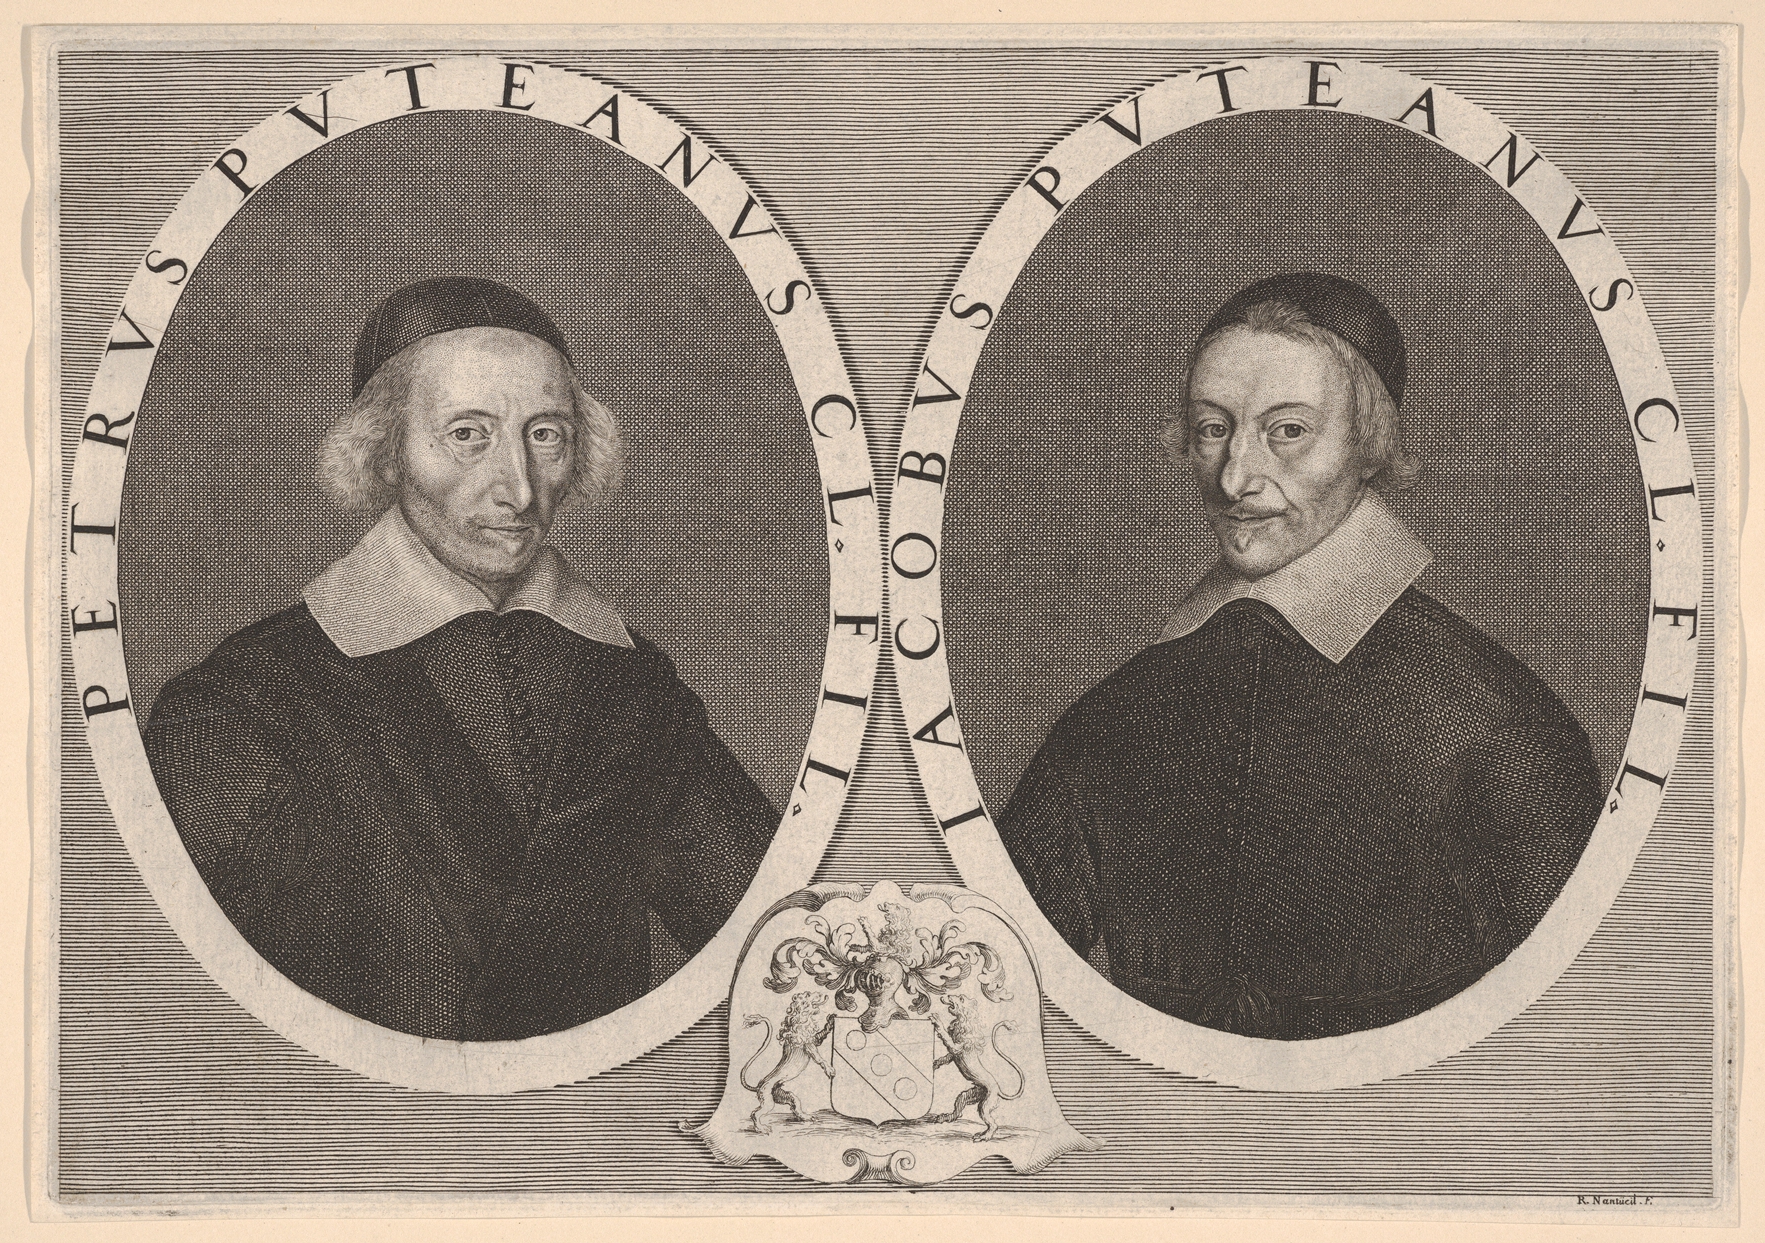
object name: print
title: Pierre and Jacques Dupuy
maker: robert nanteuil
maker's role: artist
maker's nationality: french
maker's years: 1623-1678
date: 1648-1649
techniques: engraving, etching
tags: men,portraits,coat of arms